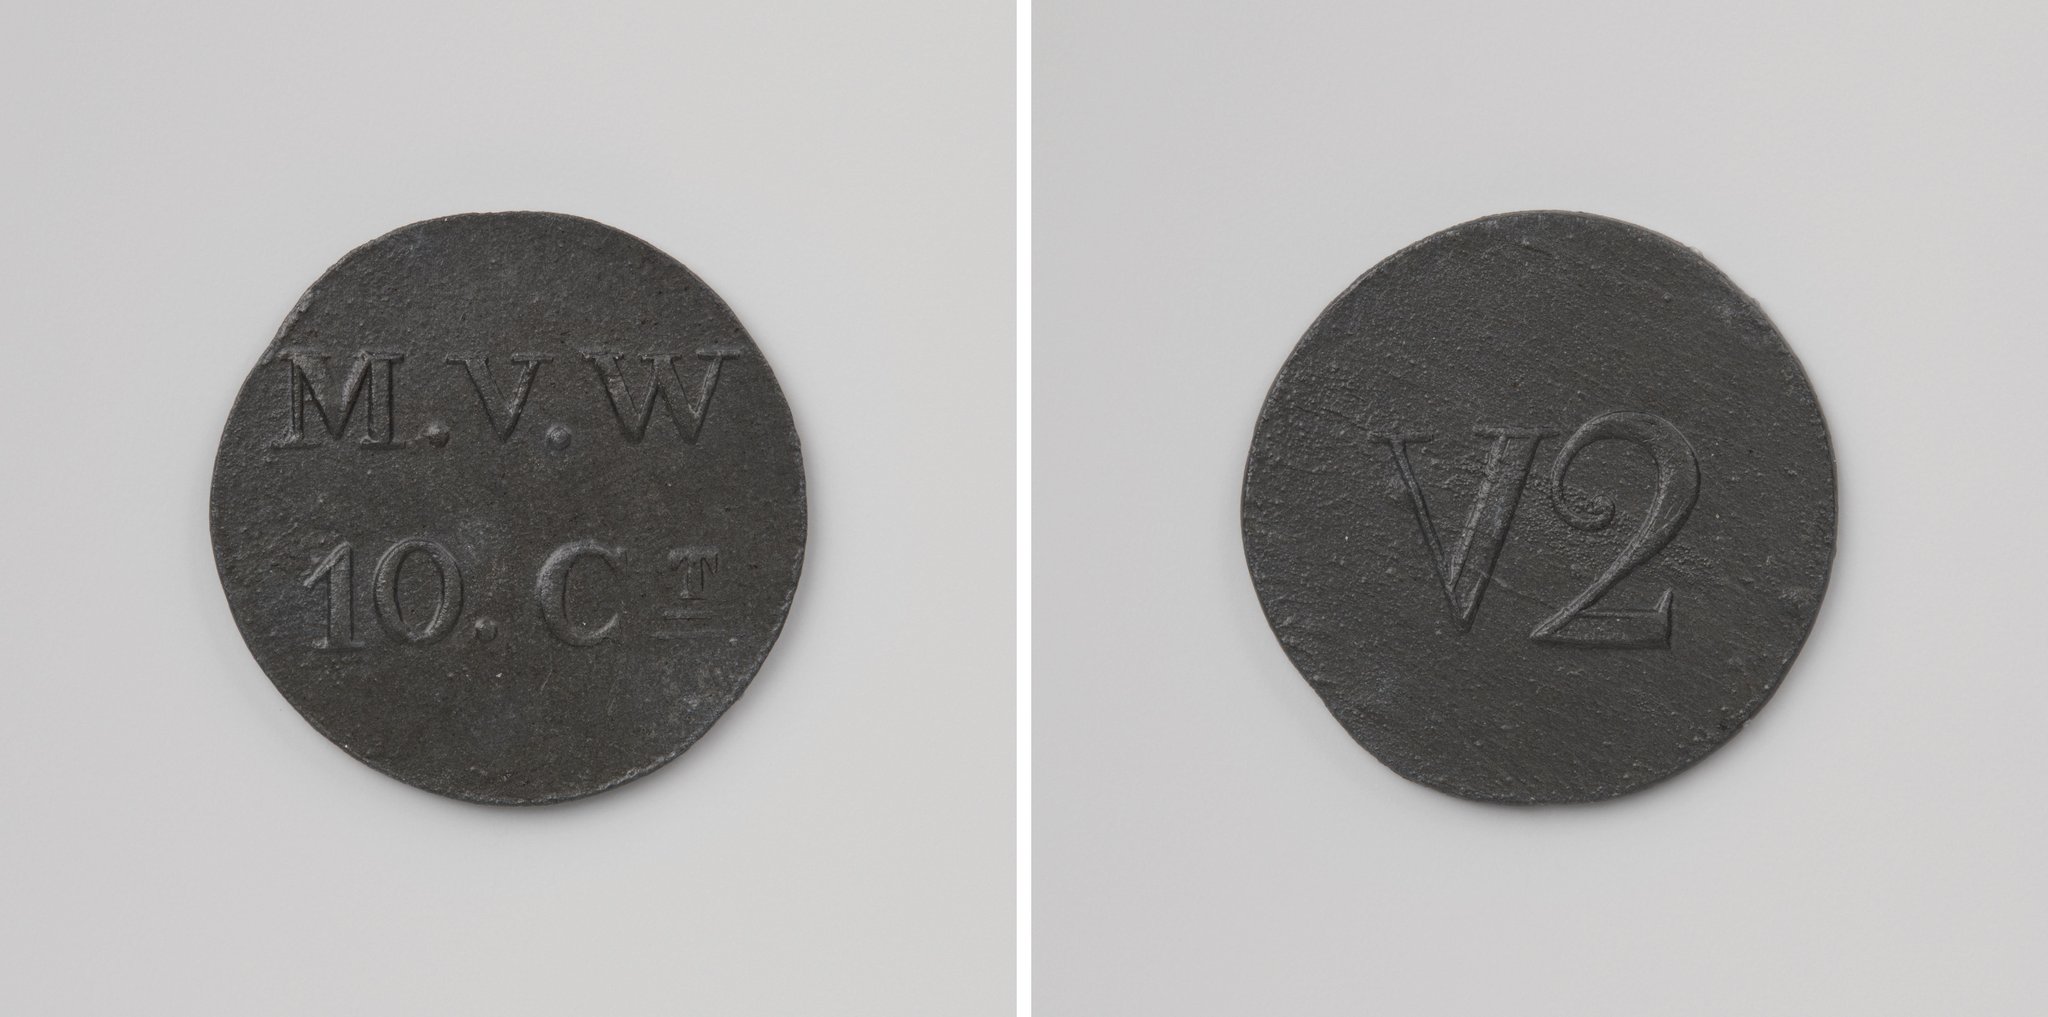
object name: monetary token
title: Tweede gesticht van de strafkolonie Veenhuizen, huismunt geslagen op last van de Maatschappij van Weldadigheid ter waarde van tien cent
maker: Anonymous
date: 1818-1859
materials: zinc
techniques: striking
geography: netherlands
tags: maatschappij van weldadigheid, veenhuizen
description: Zinken munt. Voorzijde: opschrift boven waardeaanduiding. Keerzijde: opschrift V 2